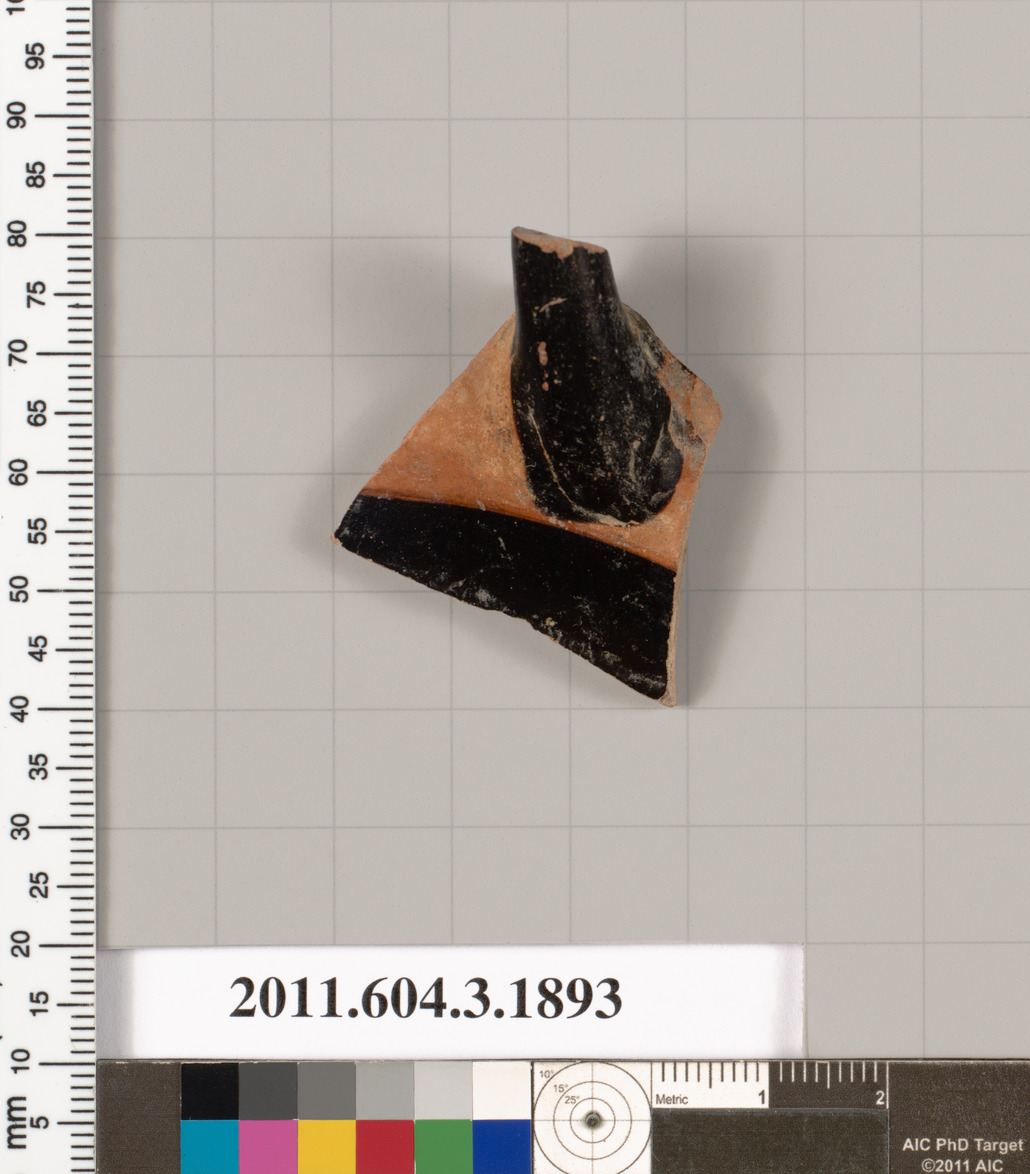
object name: kylix or skyphos fragment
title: Terracotta fragment of a kylix (drinking cup) or a skyphos (deep drinking cup)?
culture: greek, attic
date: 600-401 BCE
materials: terracotta